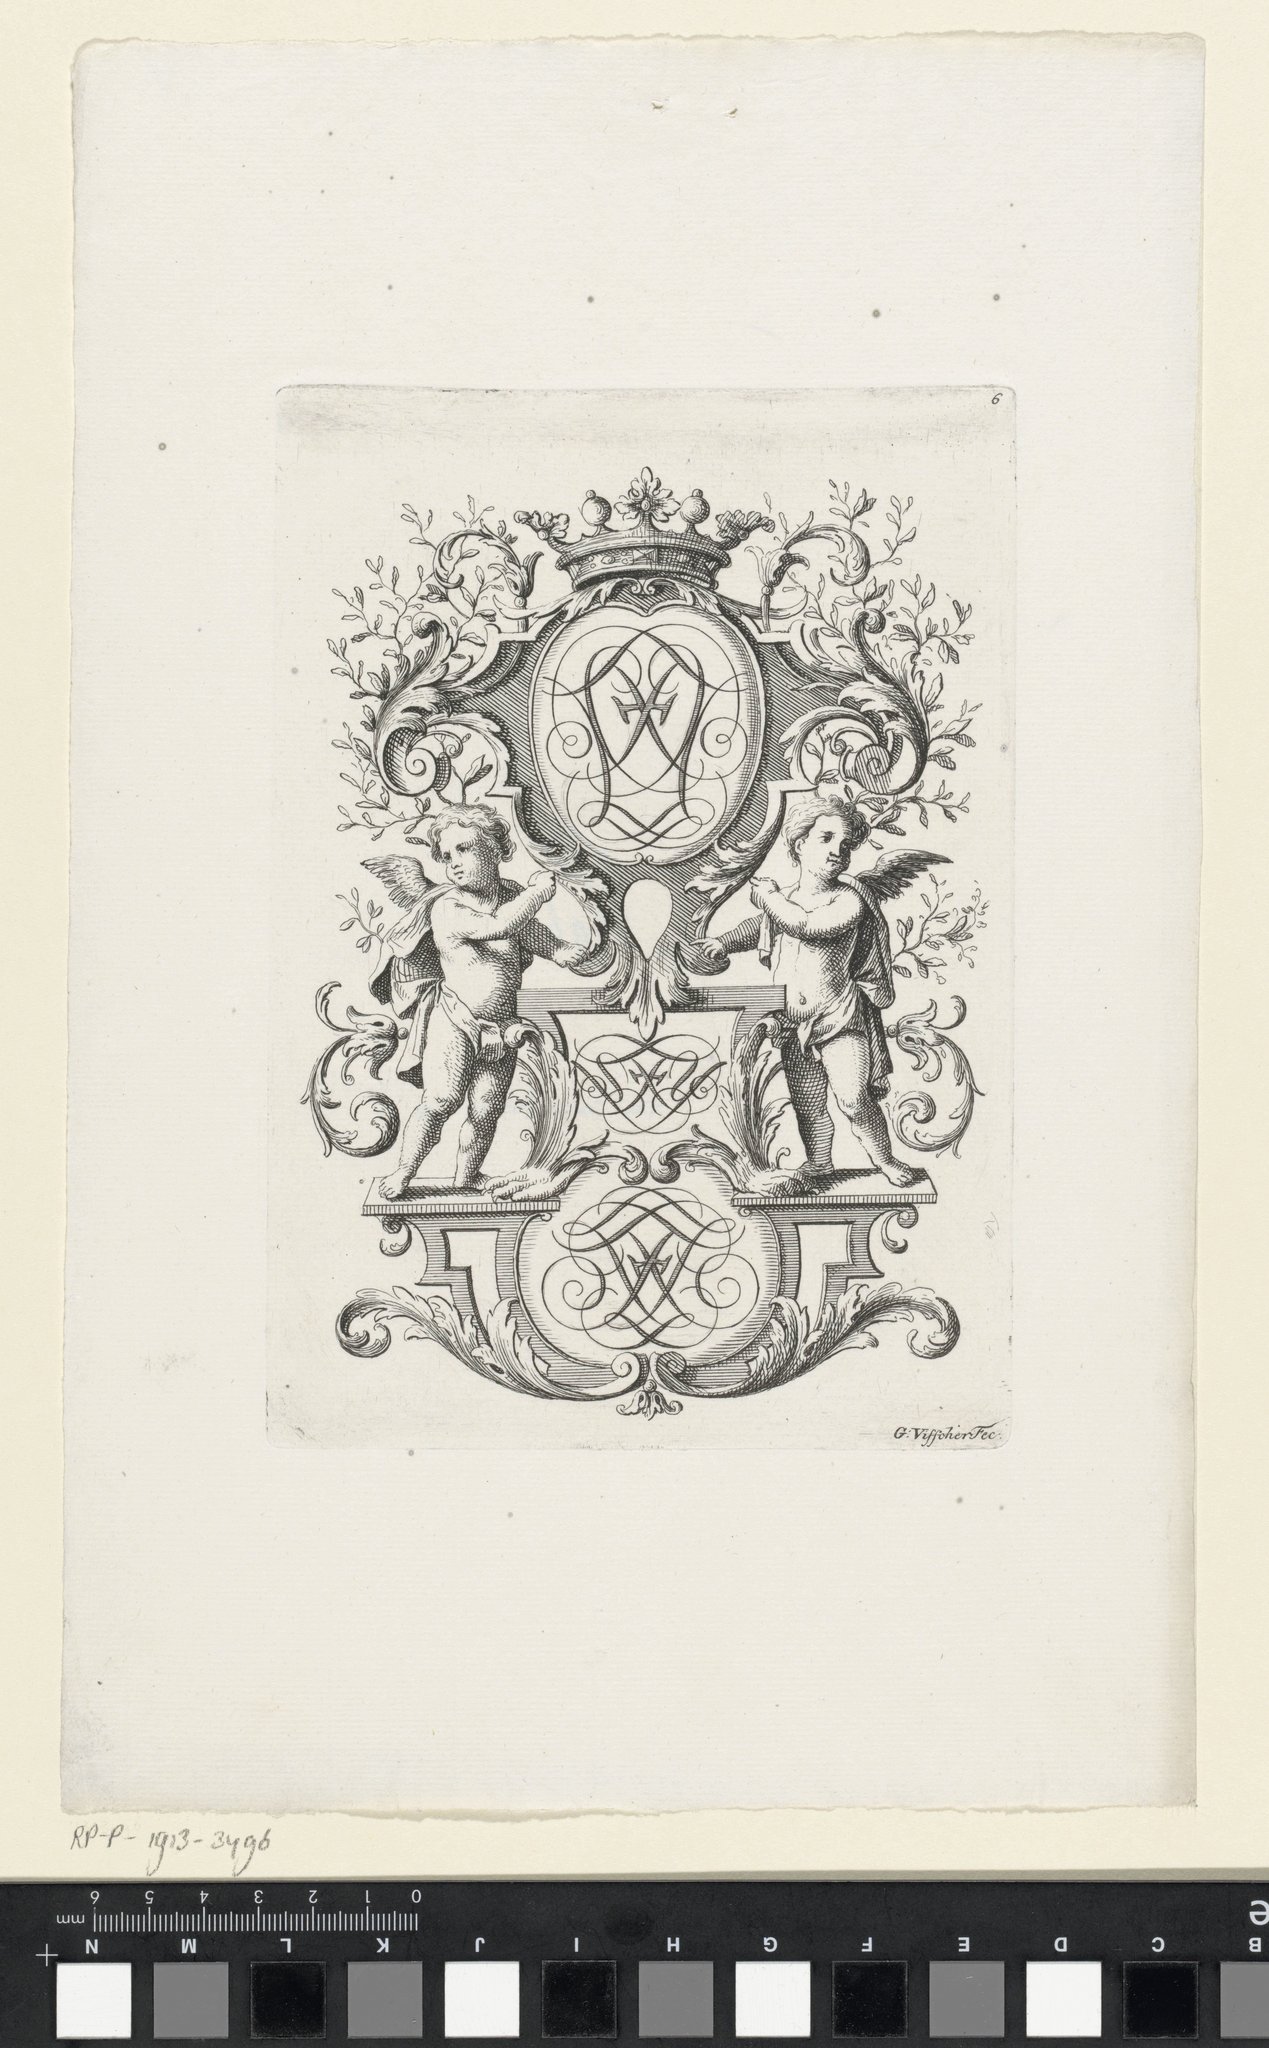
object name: ornament print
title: Het Sesde deel nieuwe t' Saam Gevlogte Naam Letteren gemaakt Door Gerrit Visscher woondt op de Singel bij de Beulingsloot tot Amsterdam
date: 1690-1710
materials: paper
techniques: engraving, etching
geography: amsterdam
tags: cupids: 'amores', 'amoretti', 'putti', ornament derived from plant forms, letter combinations such as letterword, anagram, letter square, monogram, etc.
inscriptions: collector's mark: Lugt 2228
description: De ornamenten mogelijk ten dele naar Alexis Loir.